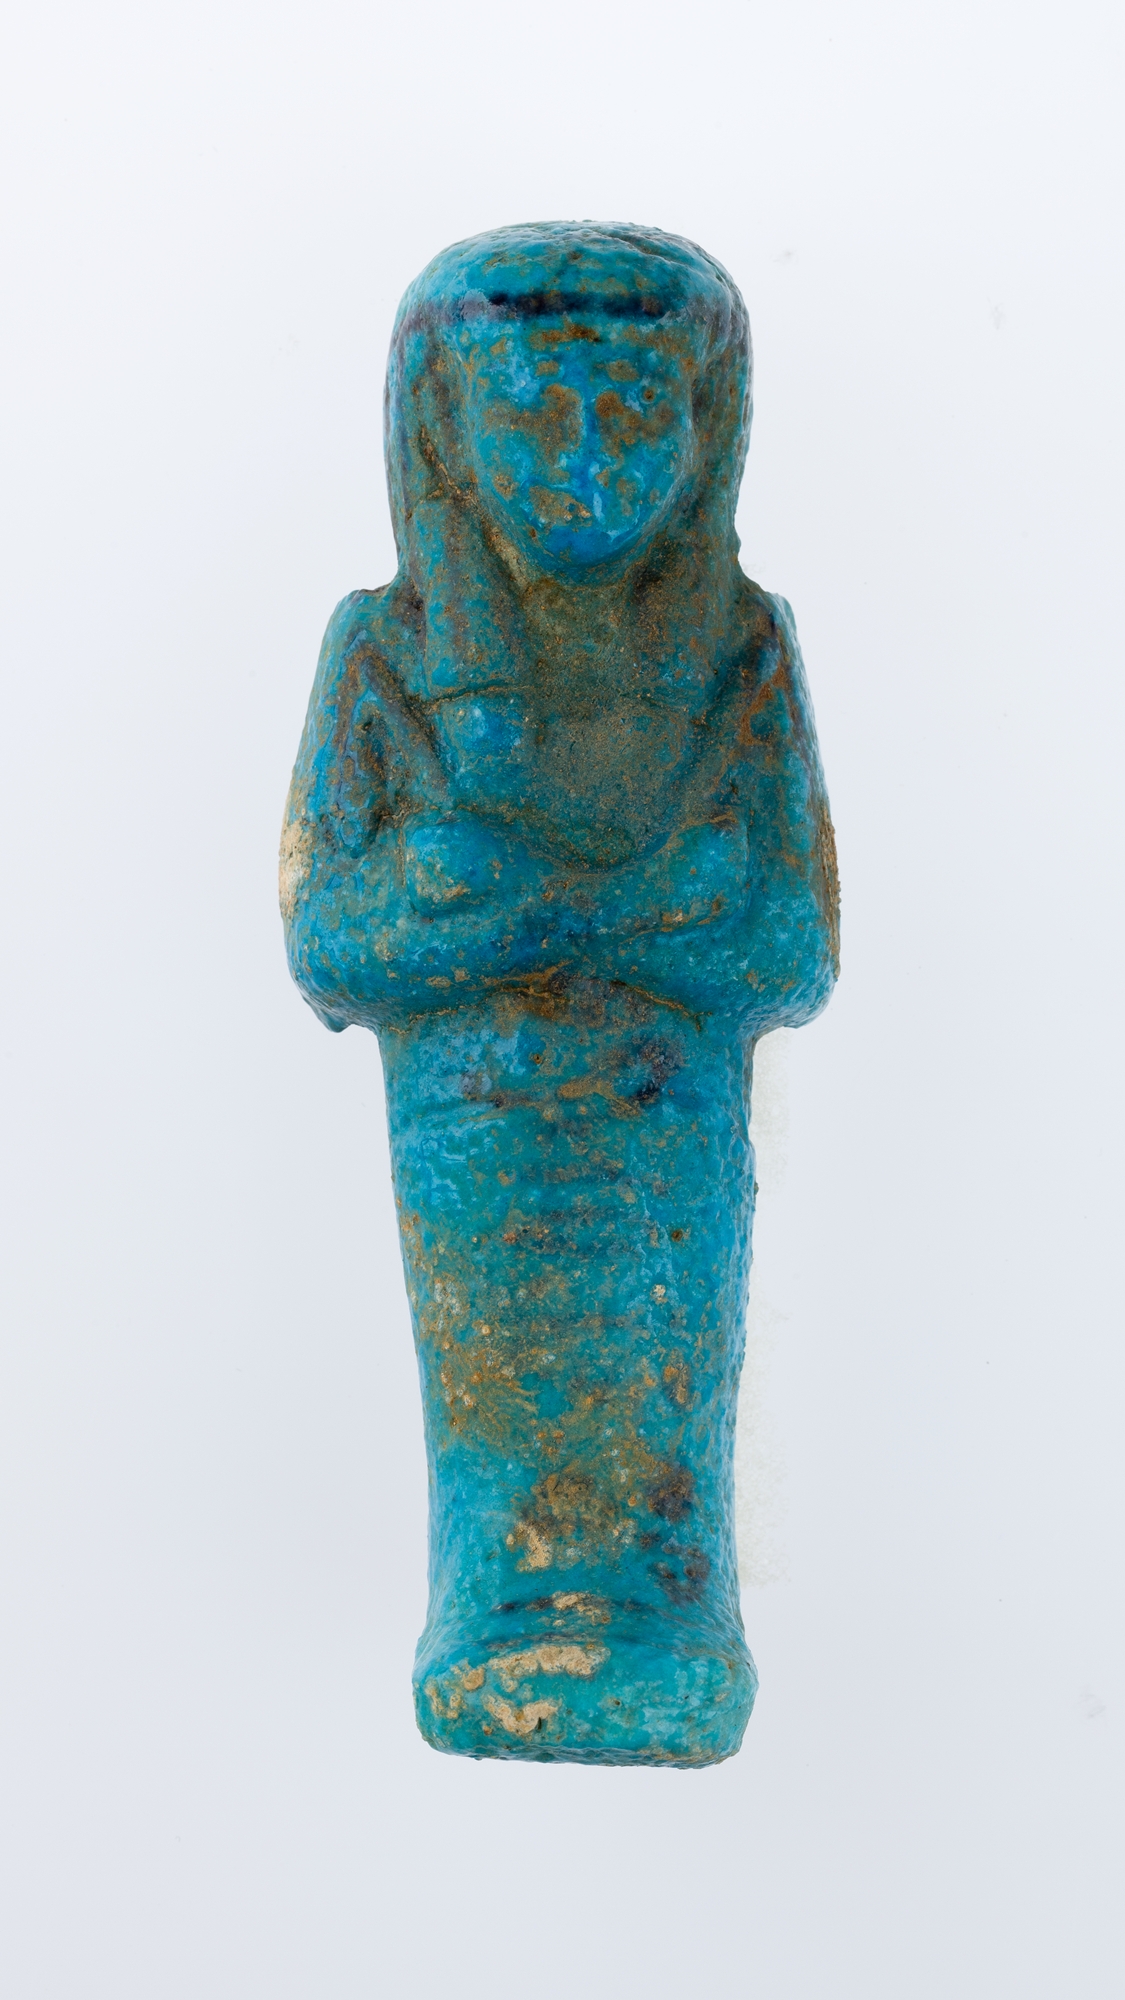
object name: shabti, henettawy c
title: Worker Shabti of Henettawy (C), Daughter of Isetemkheb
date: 990-970 BCE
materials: faience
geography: egypt